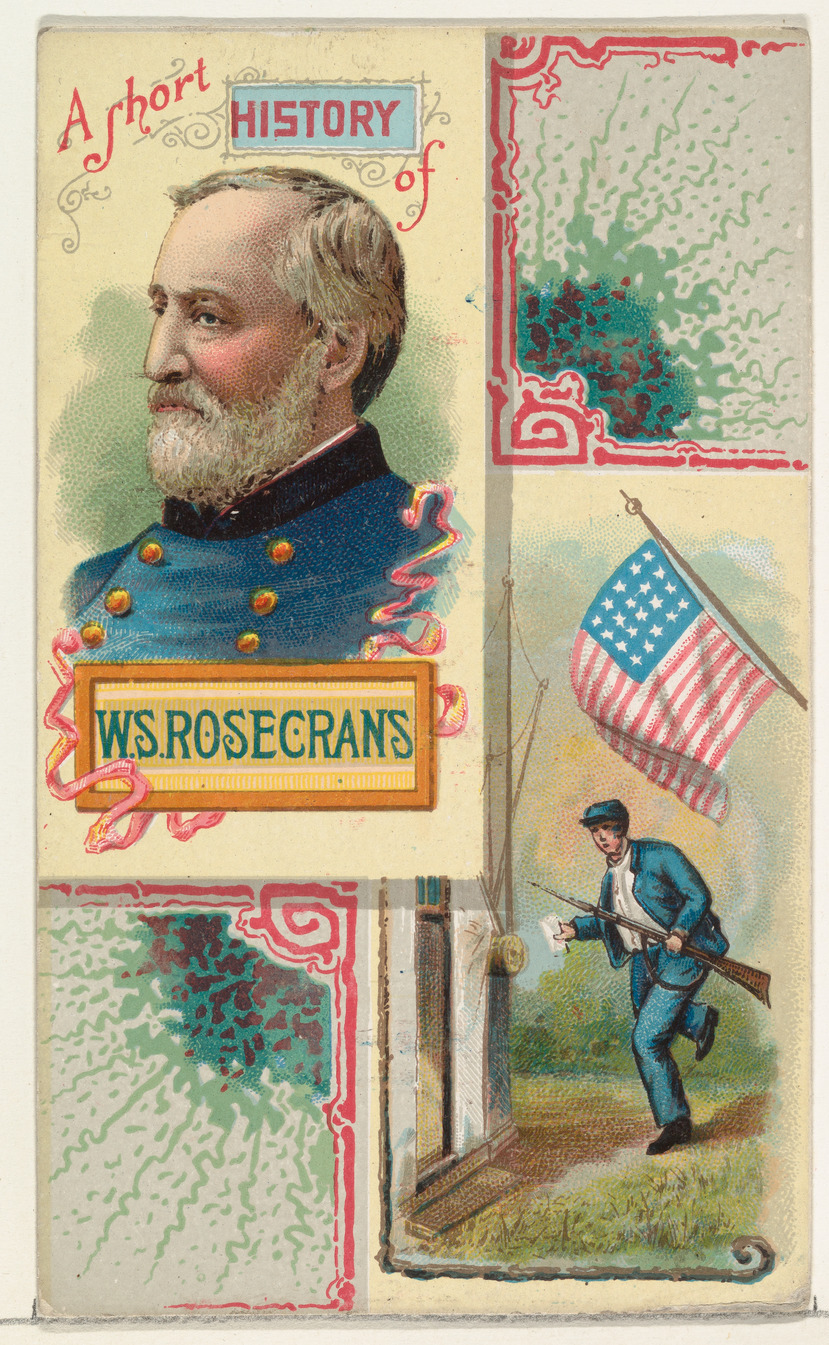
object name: print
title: A Short History: General William S. Rosecrans, from the Histories of Generals series (N114) issued by W. Duke, Sons & Co. to promote Honest Long Cut Smoking and Chewing Tobacco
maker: w. duke, sons & co.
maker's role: publisher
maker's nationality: american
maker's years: 1870-1920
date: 1888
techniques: color lithograph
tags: men,profiles,flags,generals